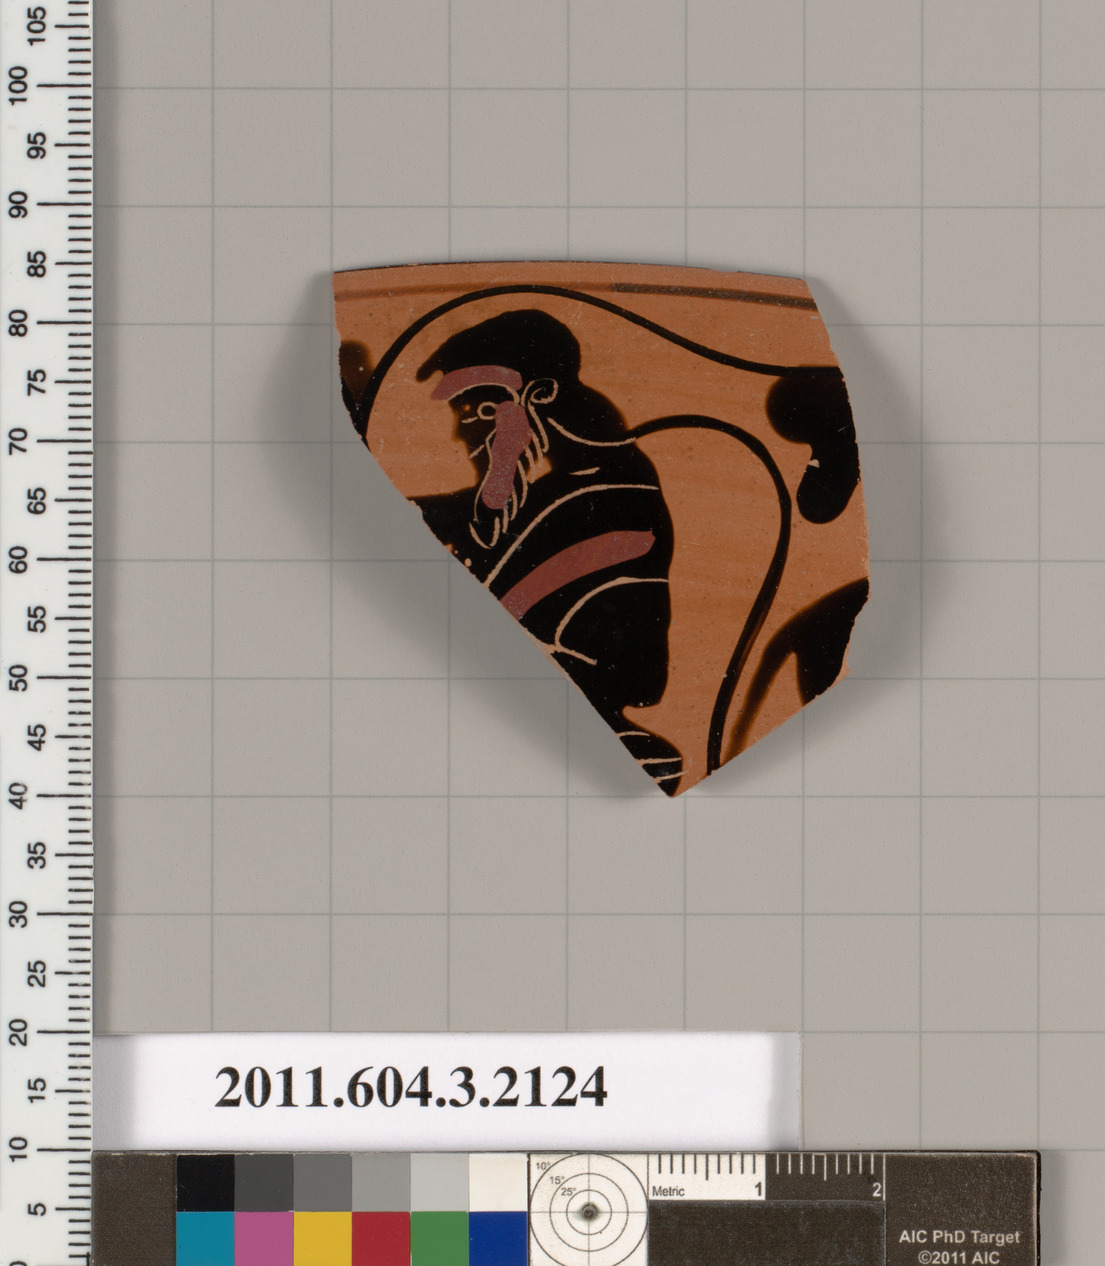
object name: kylix fragment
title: Terracotta rim fragment of a kylix (drinking cup)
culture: greek, attic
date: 534-468 BCE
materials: terracotta